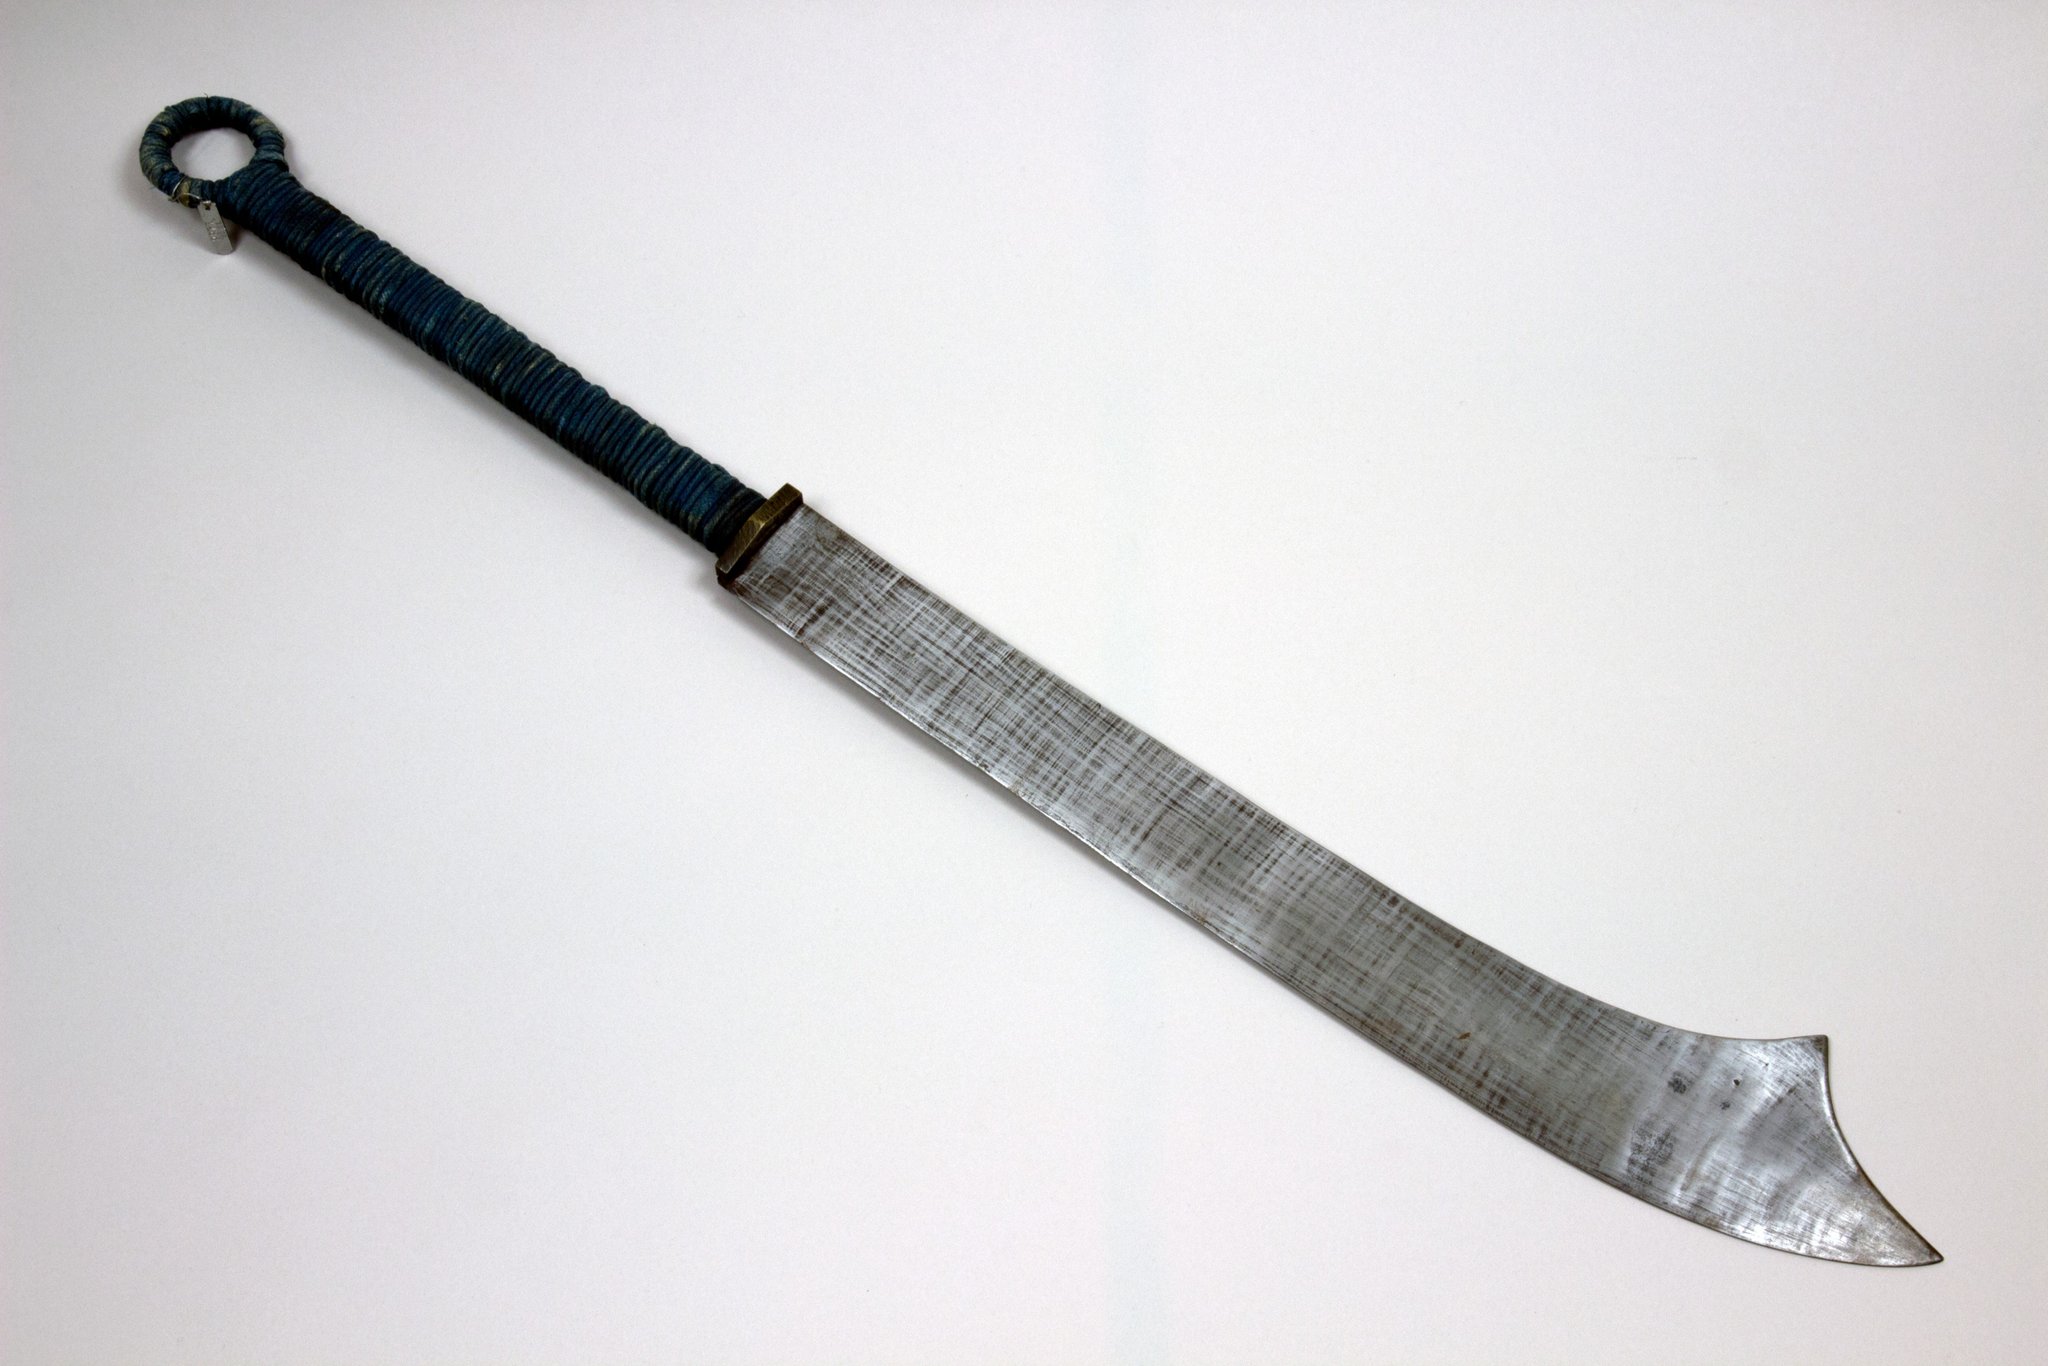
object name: sword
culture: chinese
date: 1701-1900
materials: cord, steel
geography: china